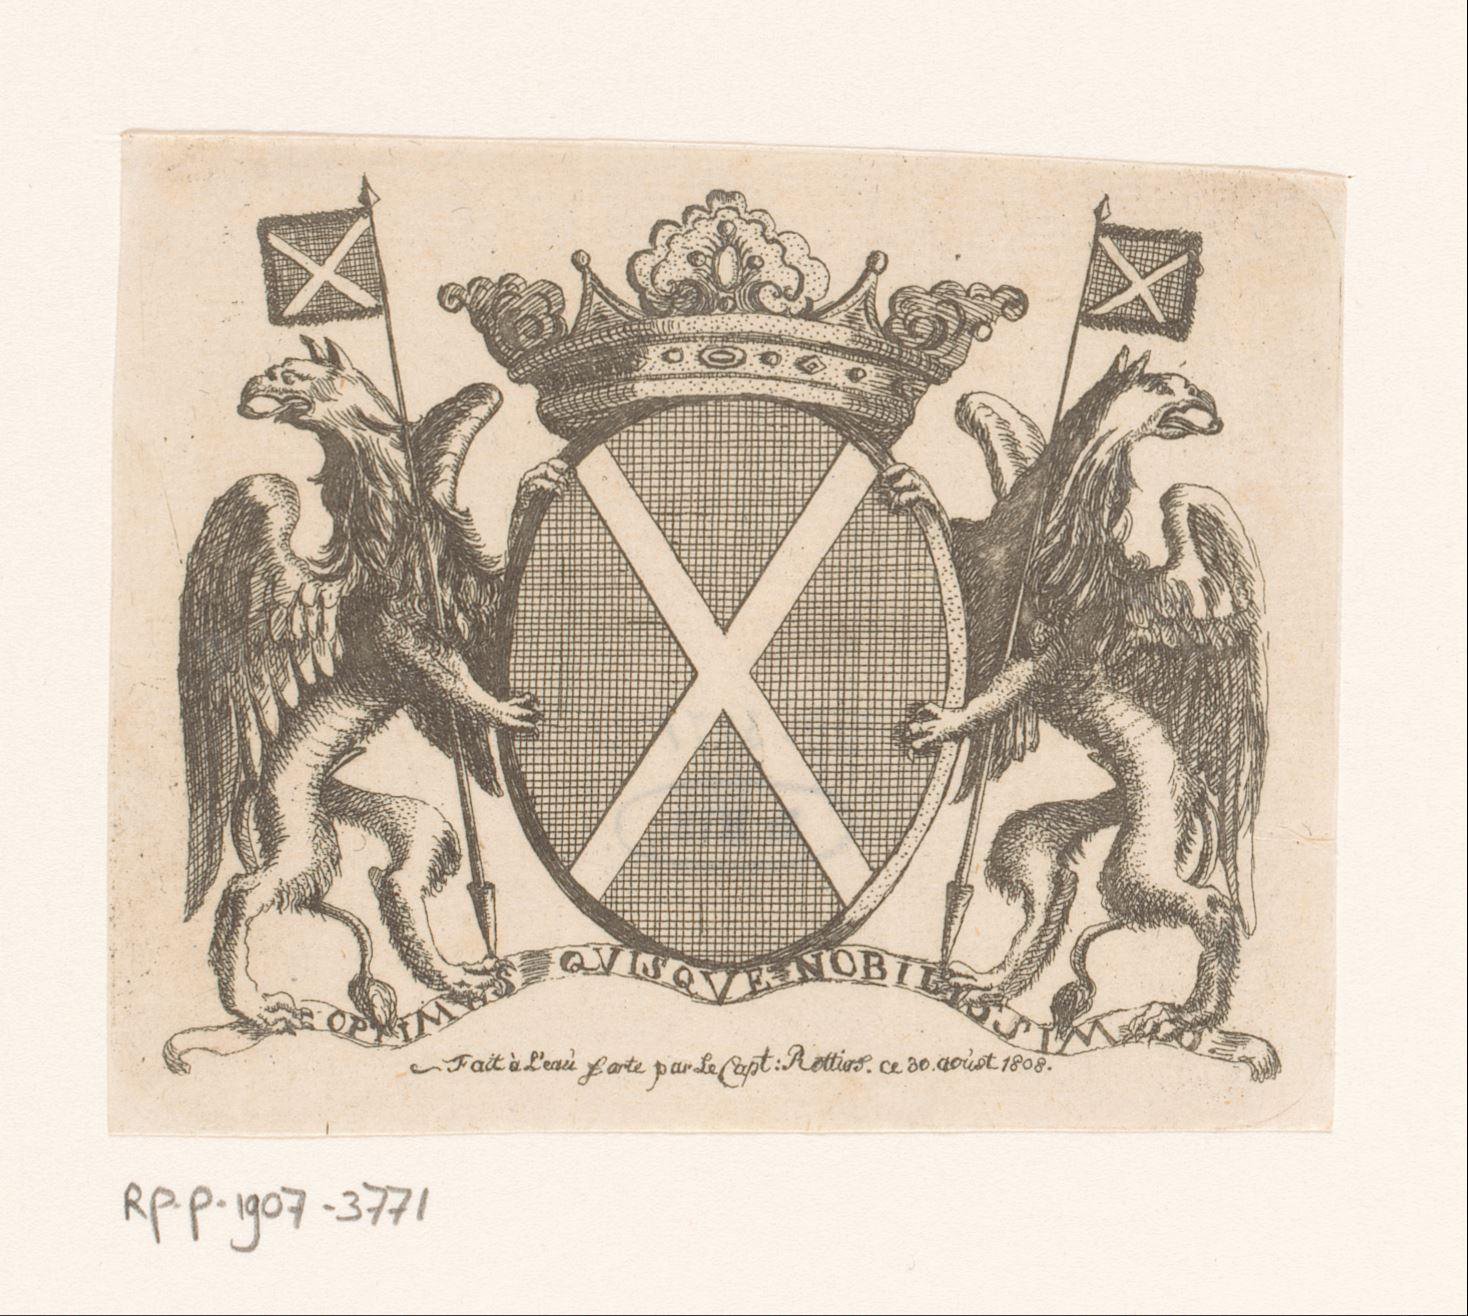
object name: print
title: Wapen met kruis geflankeerd door griffioenen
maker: bernard eugène antoine rottiers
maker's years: 1771-1857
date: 1808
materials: paper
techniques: etching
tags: griffin (lion/eagle); 'griffo' (ripa), armorial bearing, heraldry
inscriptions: collector's mark: Lugt 2228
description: Op de banderol onder het wapen staat: Optimus quisque nobilissimo. Het wapen is dat van de familie Hoeufft.